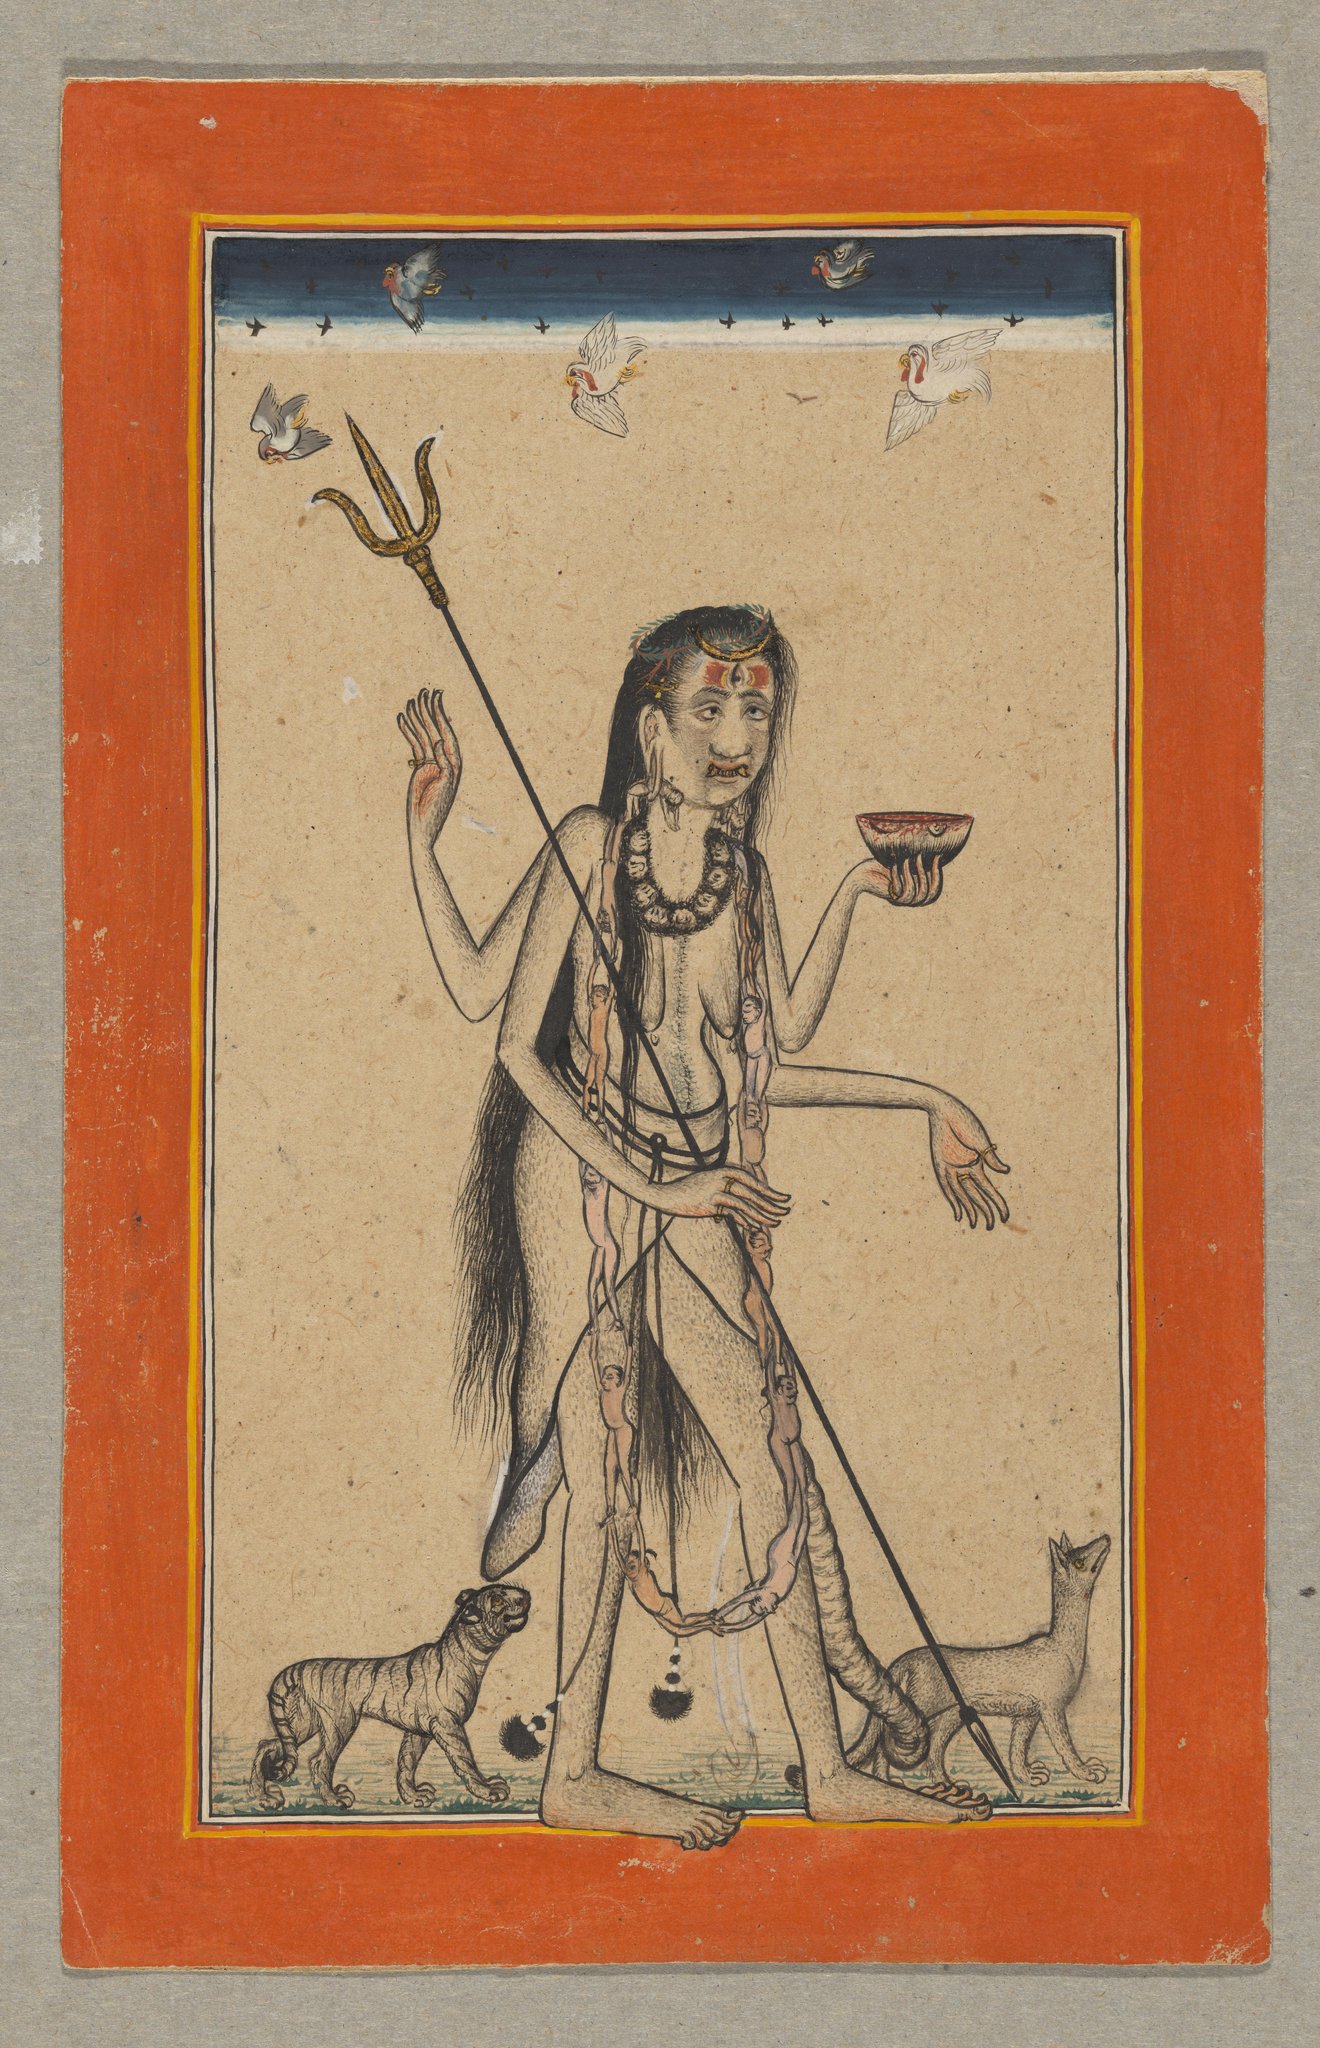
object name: indian miniature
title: Hindu deity from Mandi (Himachal Pradesh, North India)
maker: Anonymous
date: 1700-1799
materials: paper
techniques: brush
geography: india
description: Bhairavi Mandi Purchased from Mr E. Isacco, Galerie Marco Polo, Paris. Published in Lauf, D. I. Terrifying Deities of Vajrayana Buddhism, Galerie Marco Polo, Exposition Printemps 1978, p.103